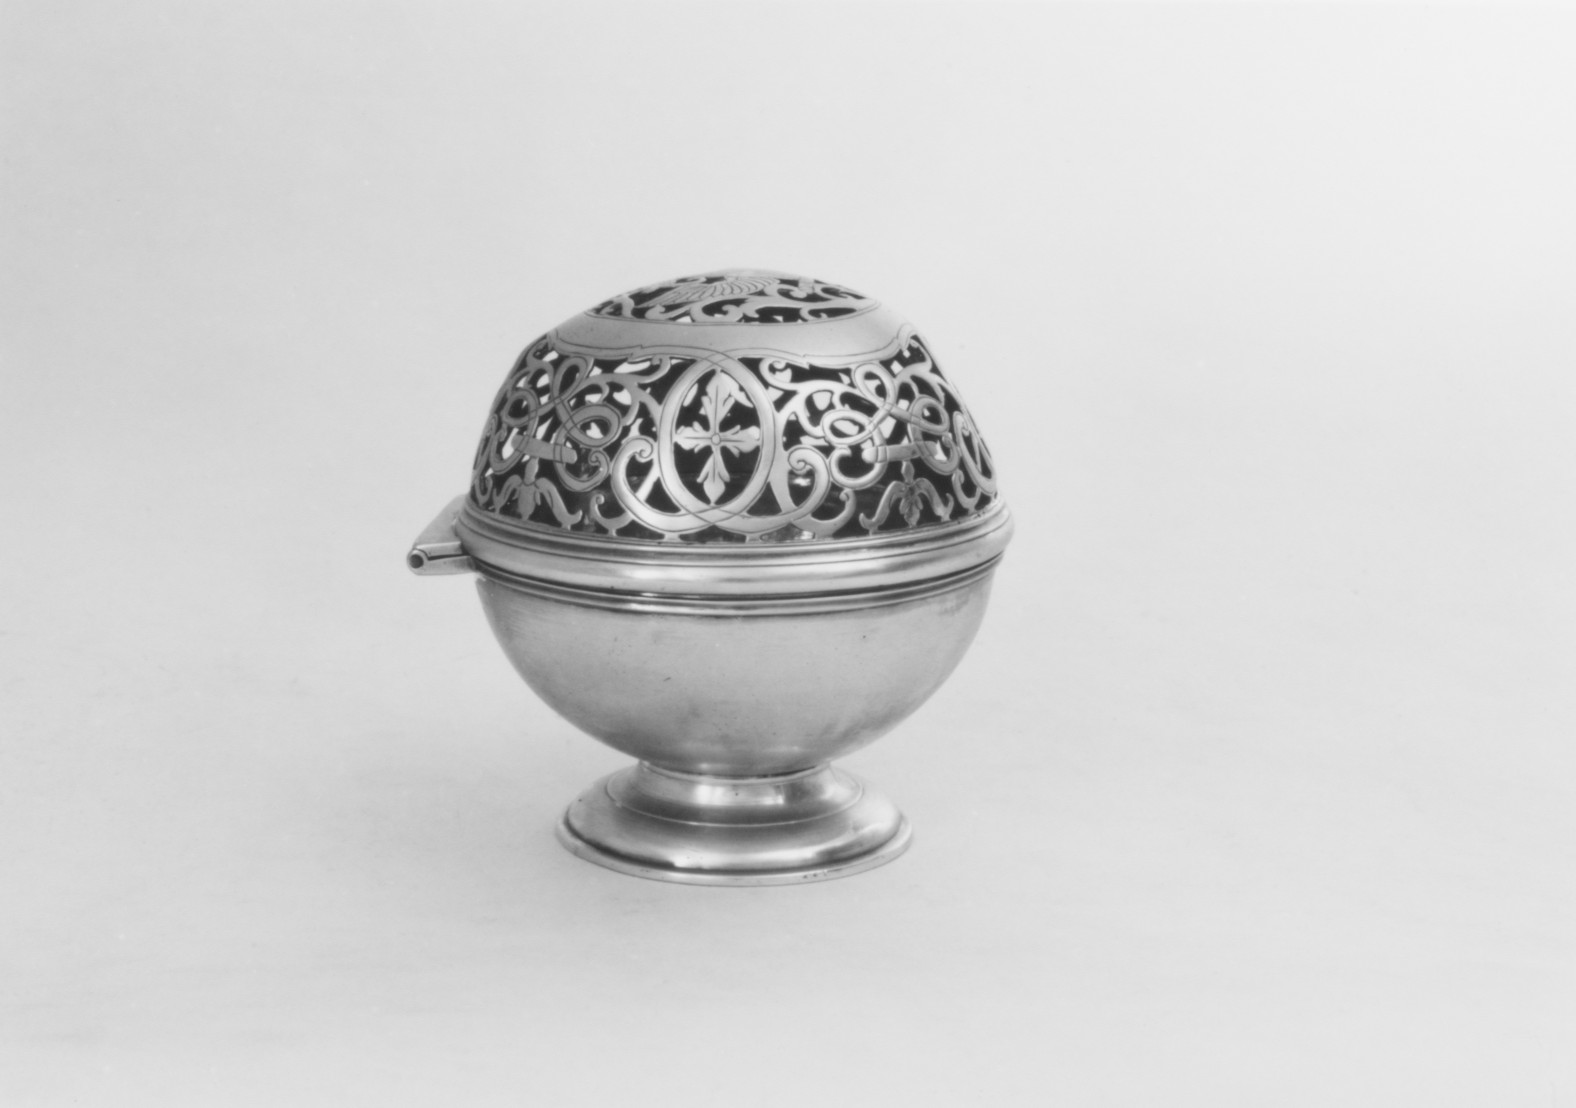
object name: sponge box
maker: d.m.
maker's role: maker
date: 1725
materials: silver